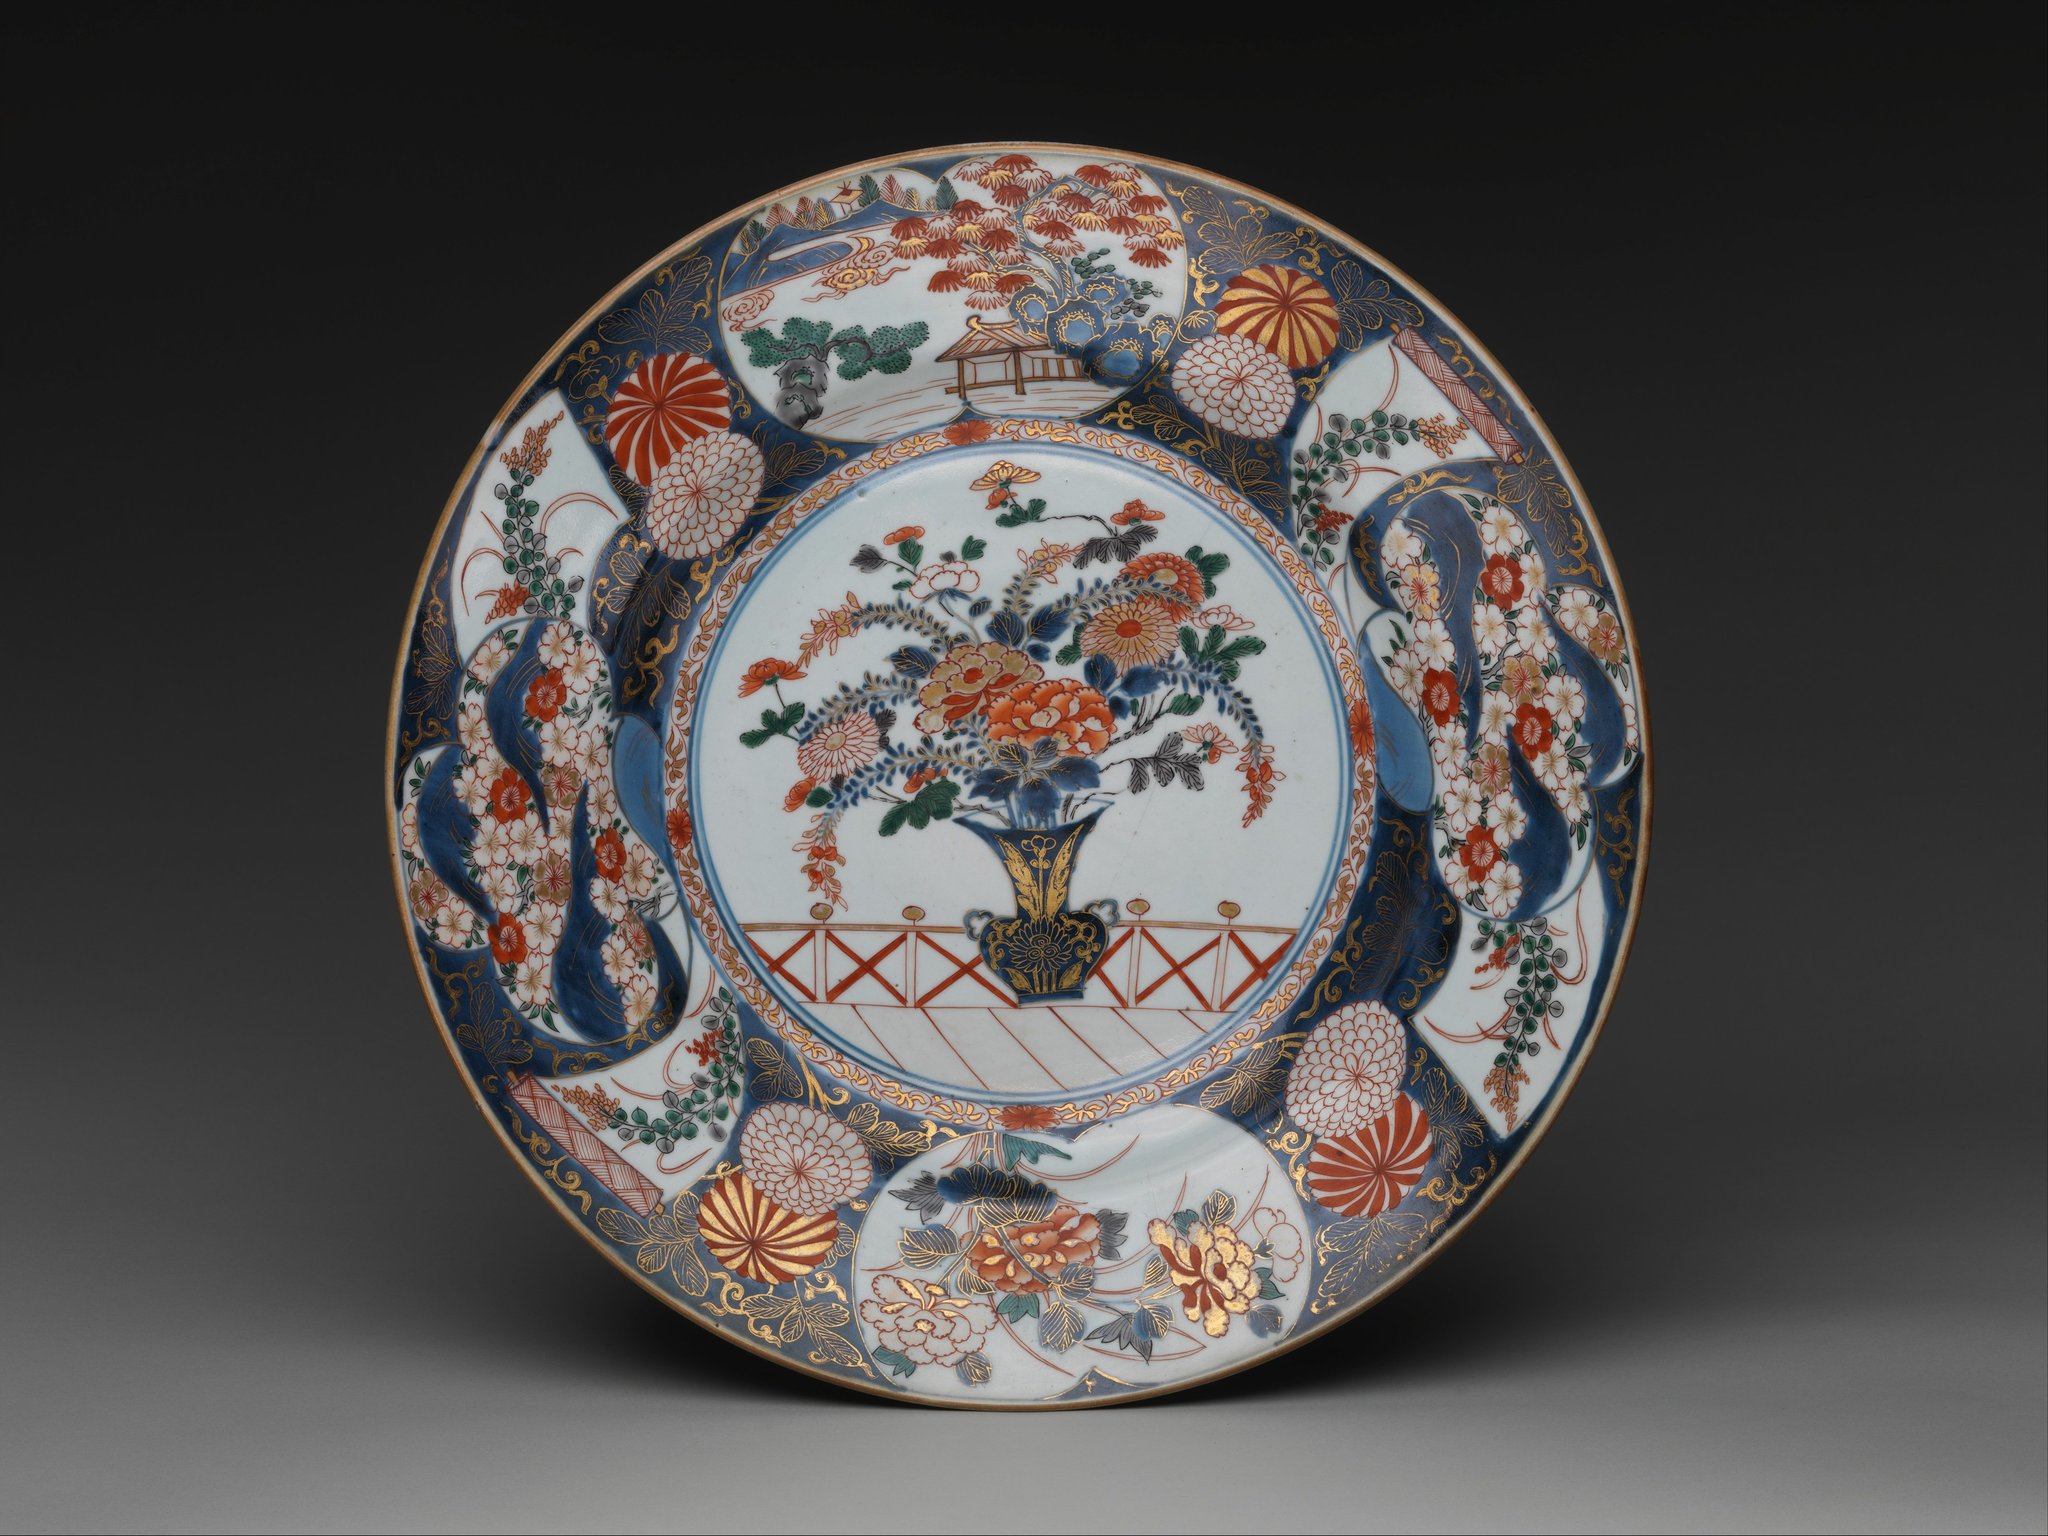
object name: plate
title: Plate with Vase and Flowers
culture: japanese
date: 1700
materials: enamel, glaze, porcelain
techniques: painting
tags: flowers